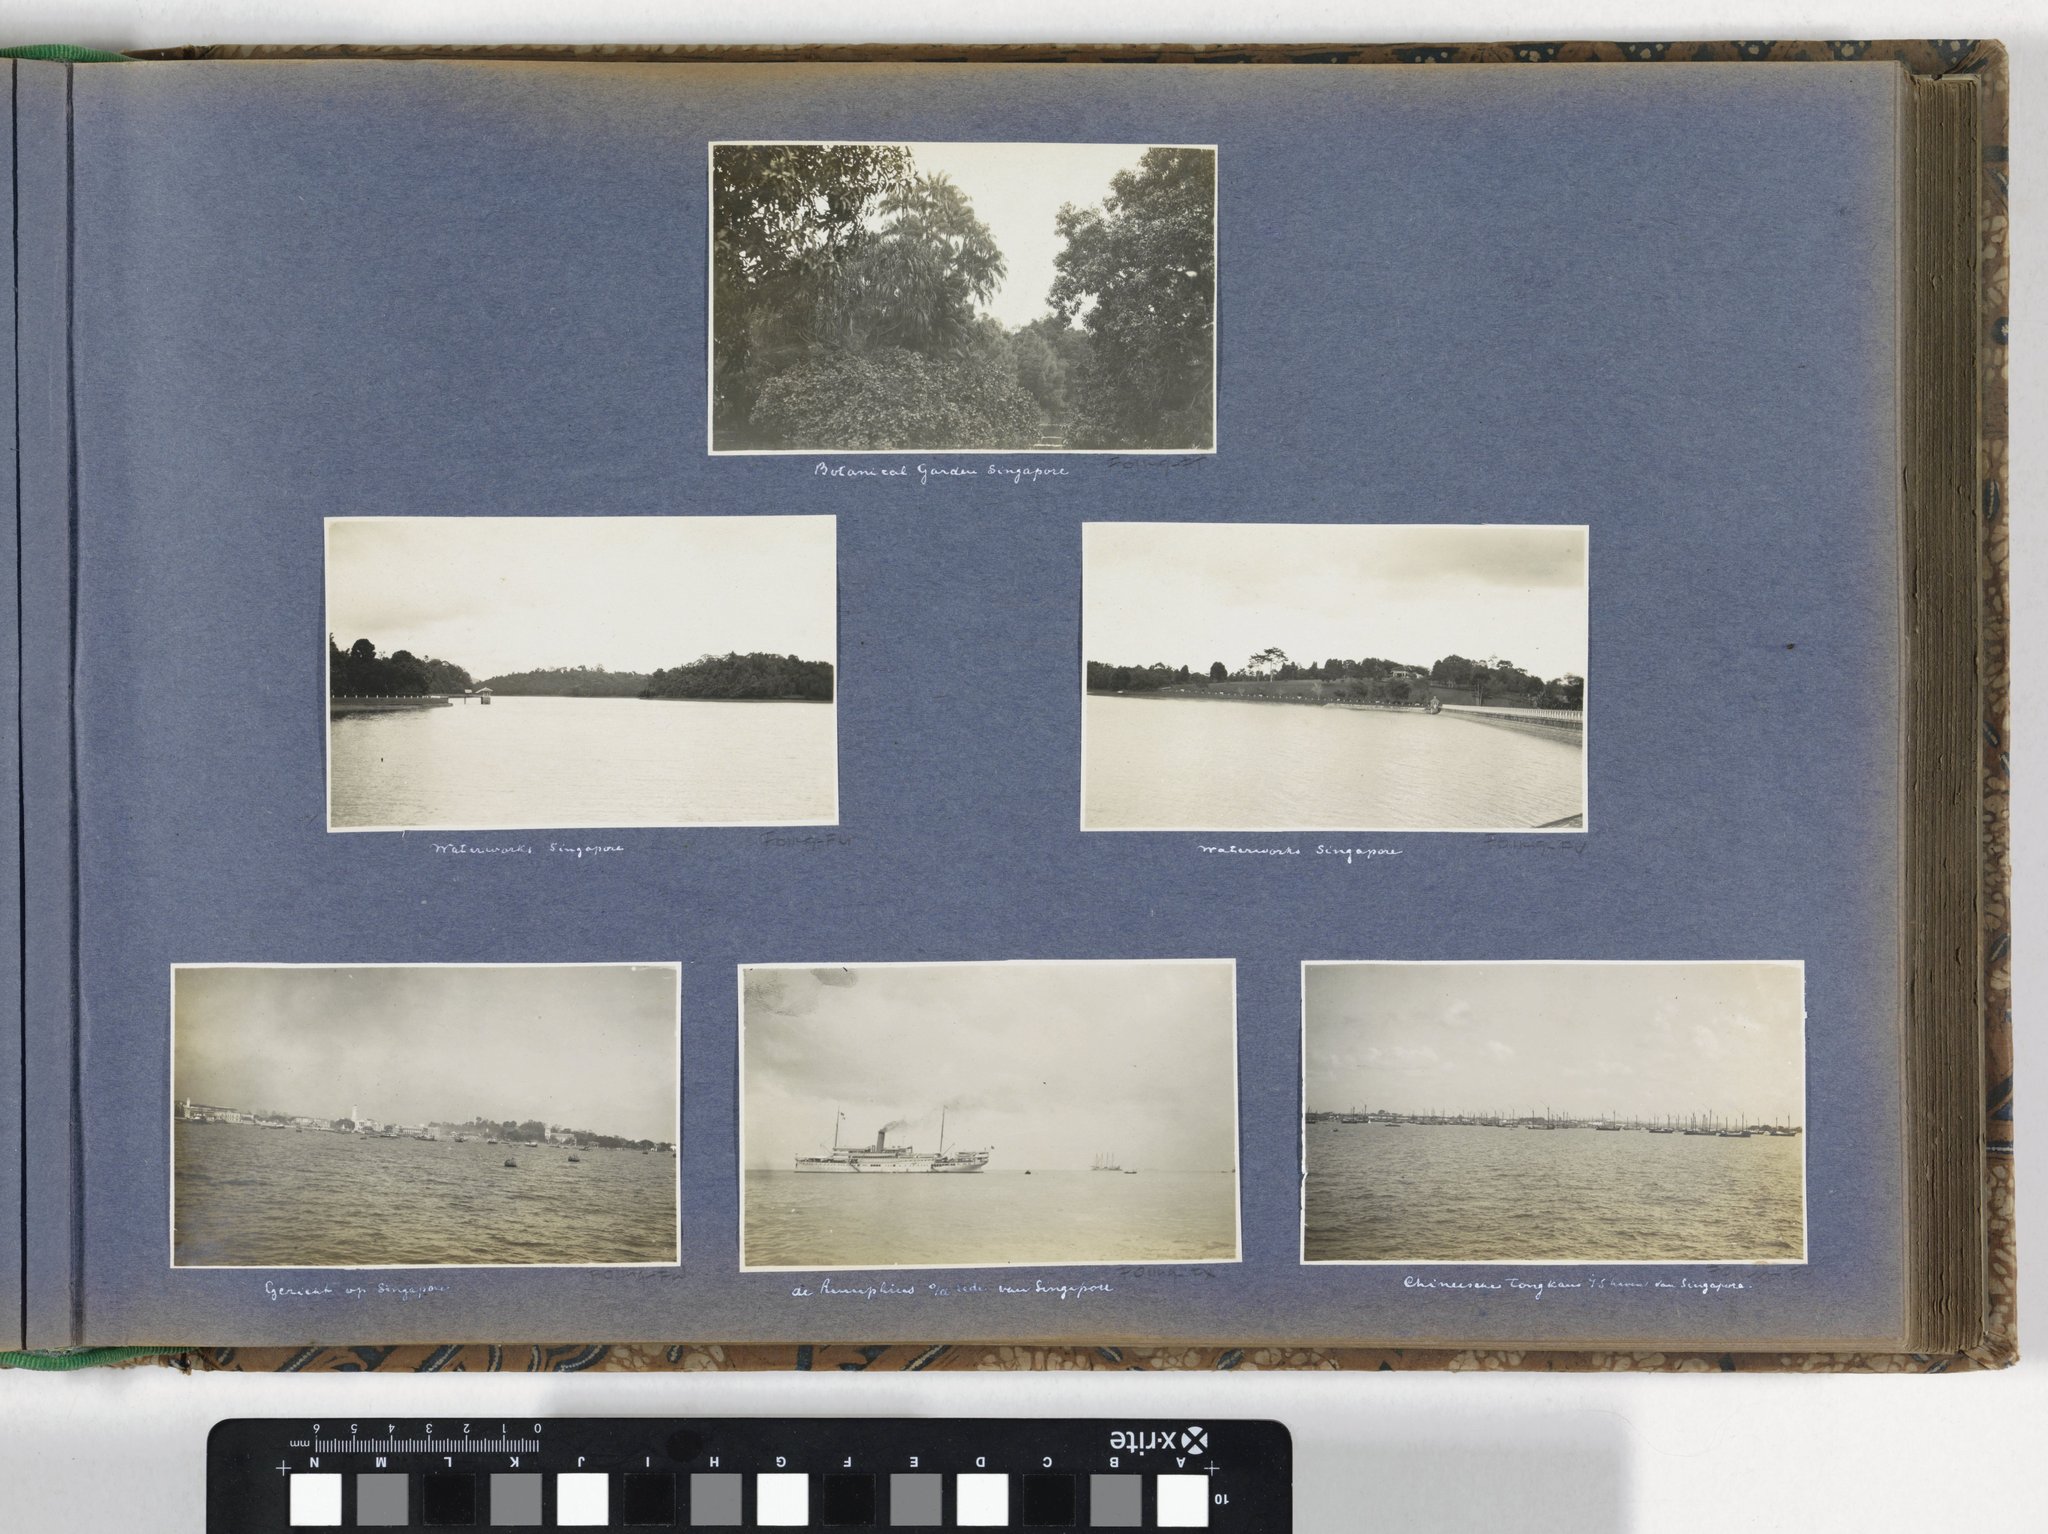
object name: album leaf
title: Water met (vermoedelijk) een dam in Singapore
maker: Anonymous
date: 1908-1920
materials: paper, photographic support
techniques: gelatin silver print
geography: singapore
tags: river, barrage, mcritchie reservoir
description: Onderdeel van reisalbum met foto's van bedrijvigheid en bezienswaardigheden op Sumatra en Java en van de reis naar en van Nederlands-Indië.